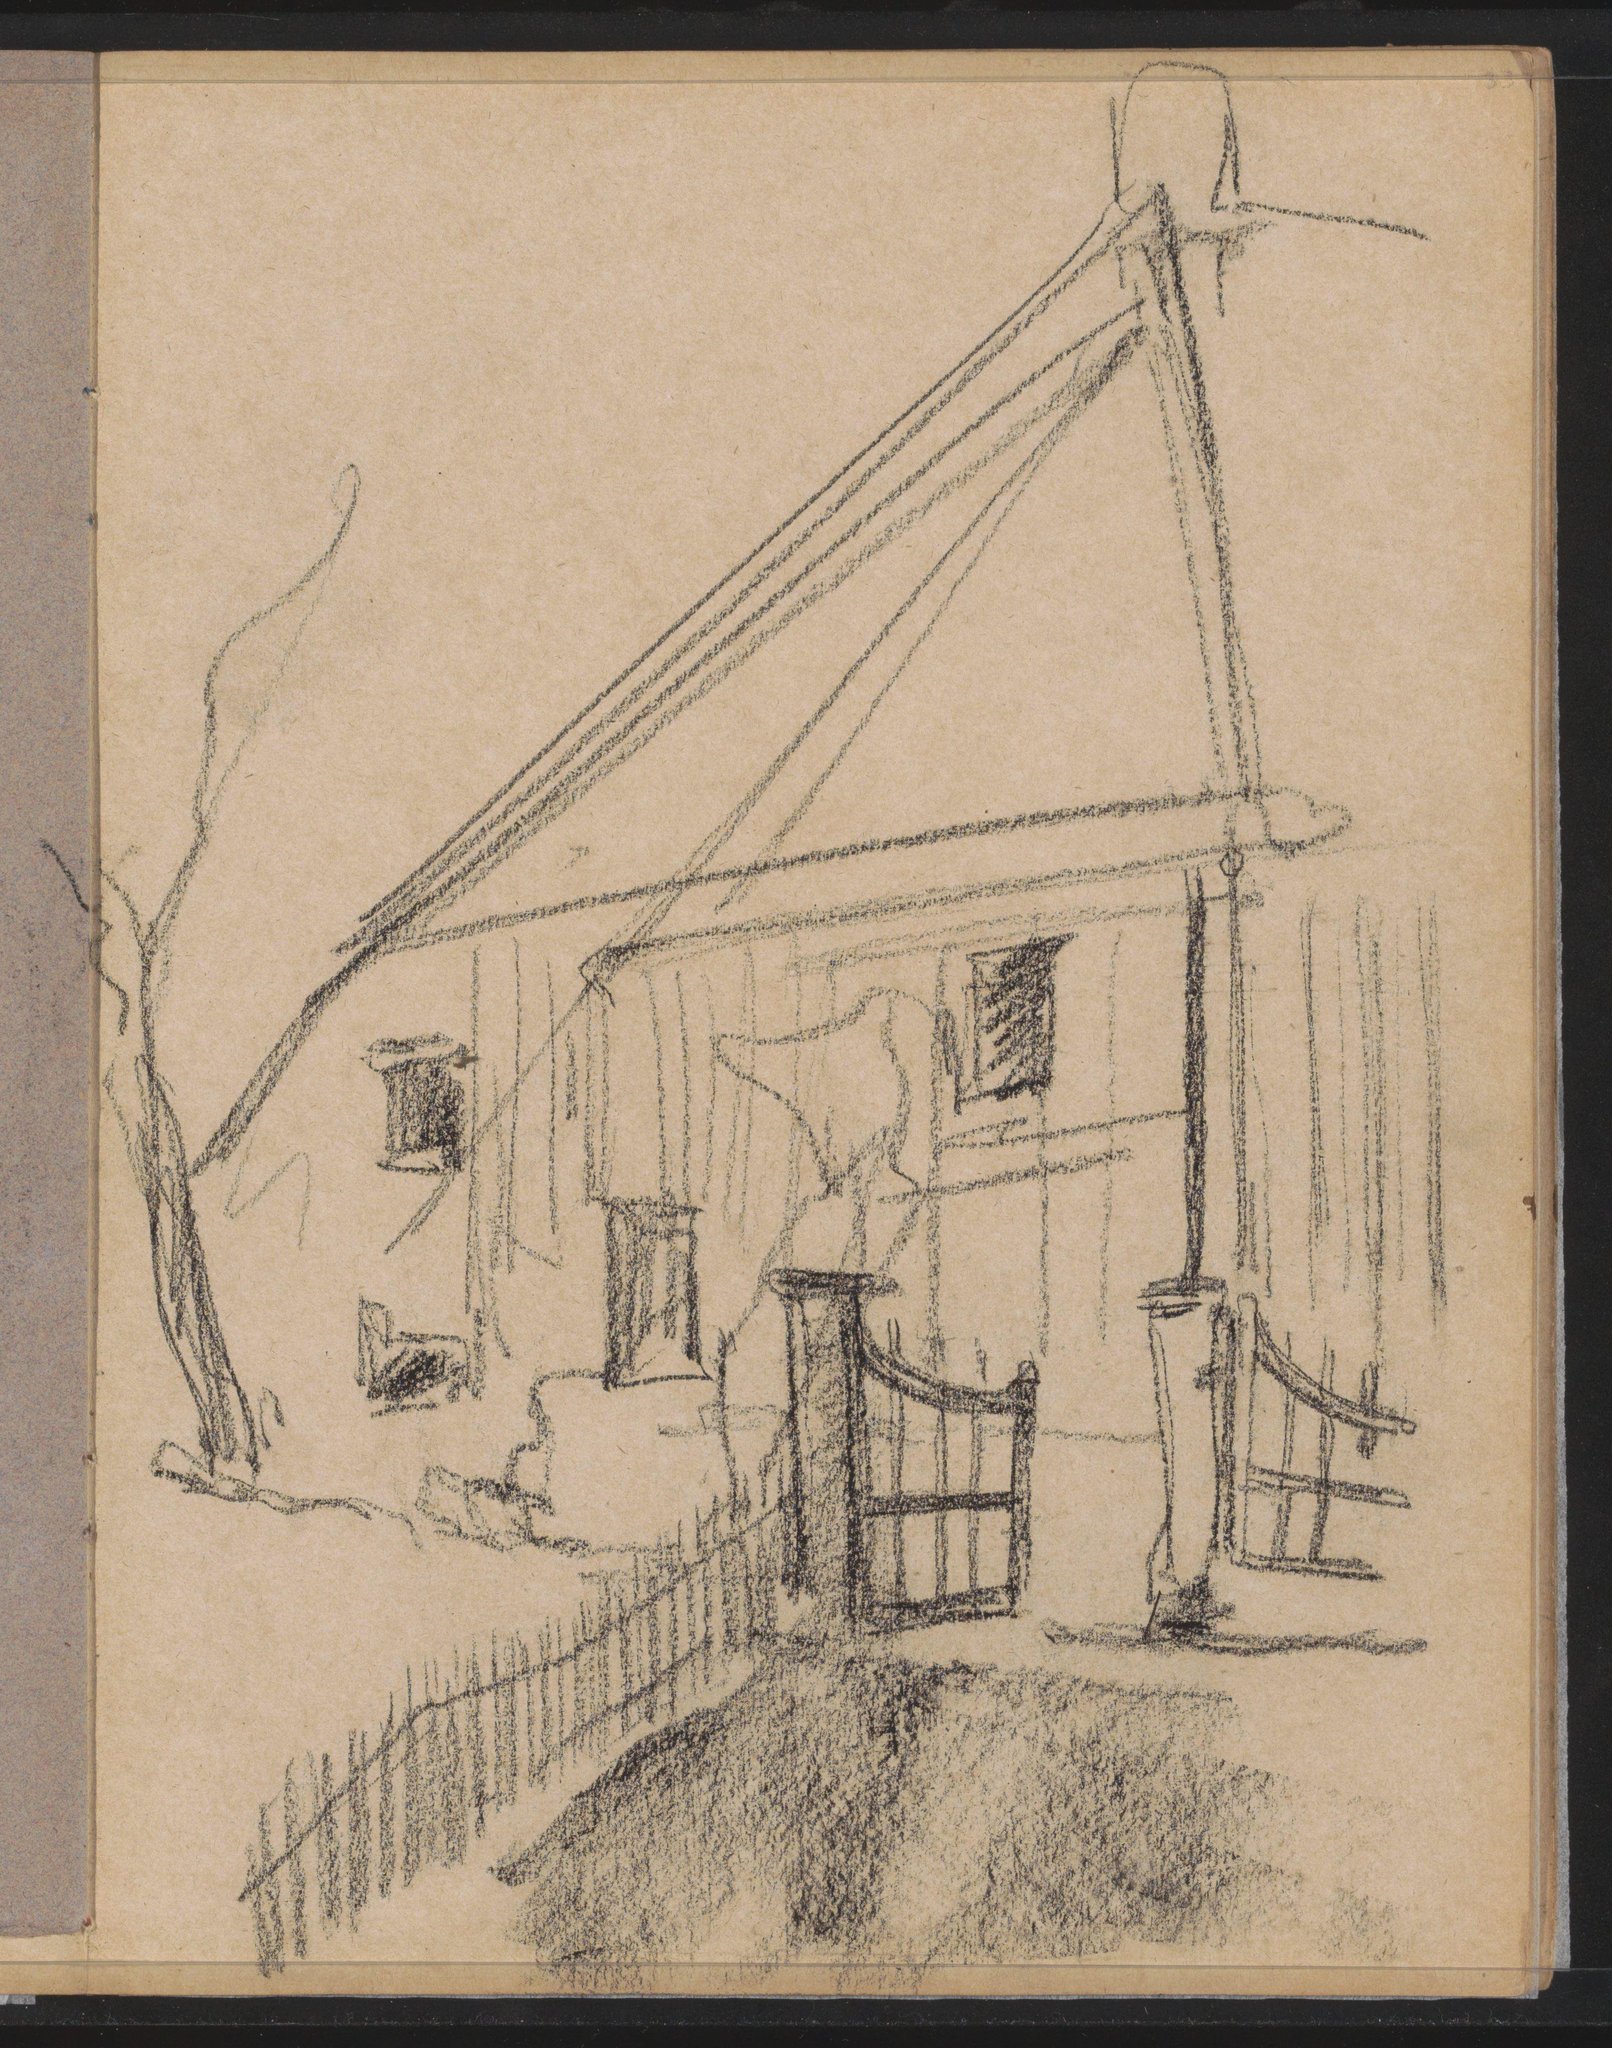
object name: sketchbook leaf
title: Boerderij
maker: willem witsen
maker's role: draughtsman, painter, print maker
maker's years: 1860-1923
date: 1887-1888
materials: chalk, paper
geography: diepenheim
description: Pagina 33 uit een schetsboek met 43 bladen.